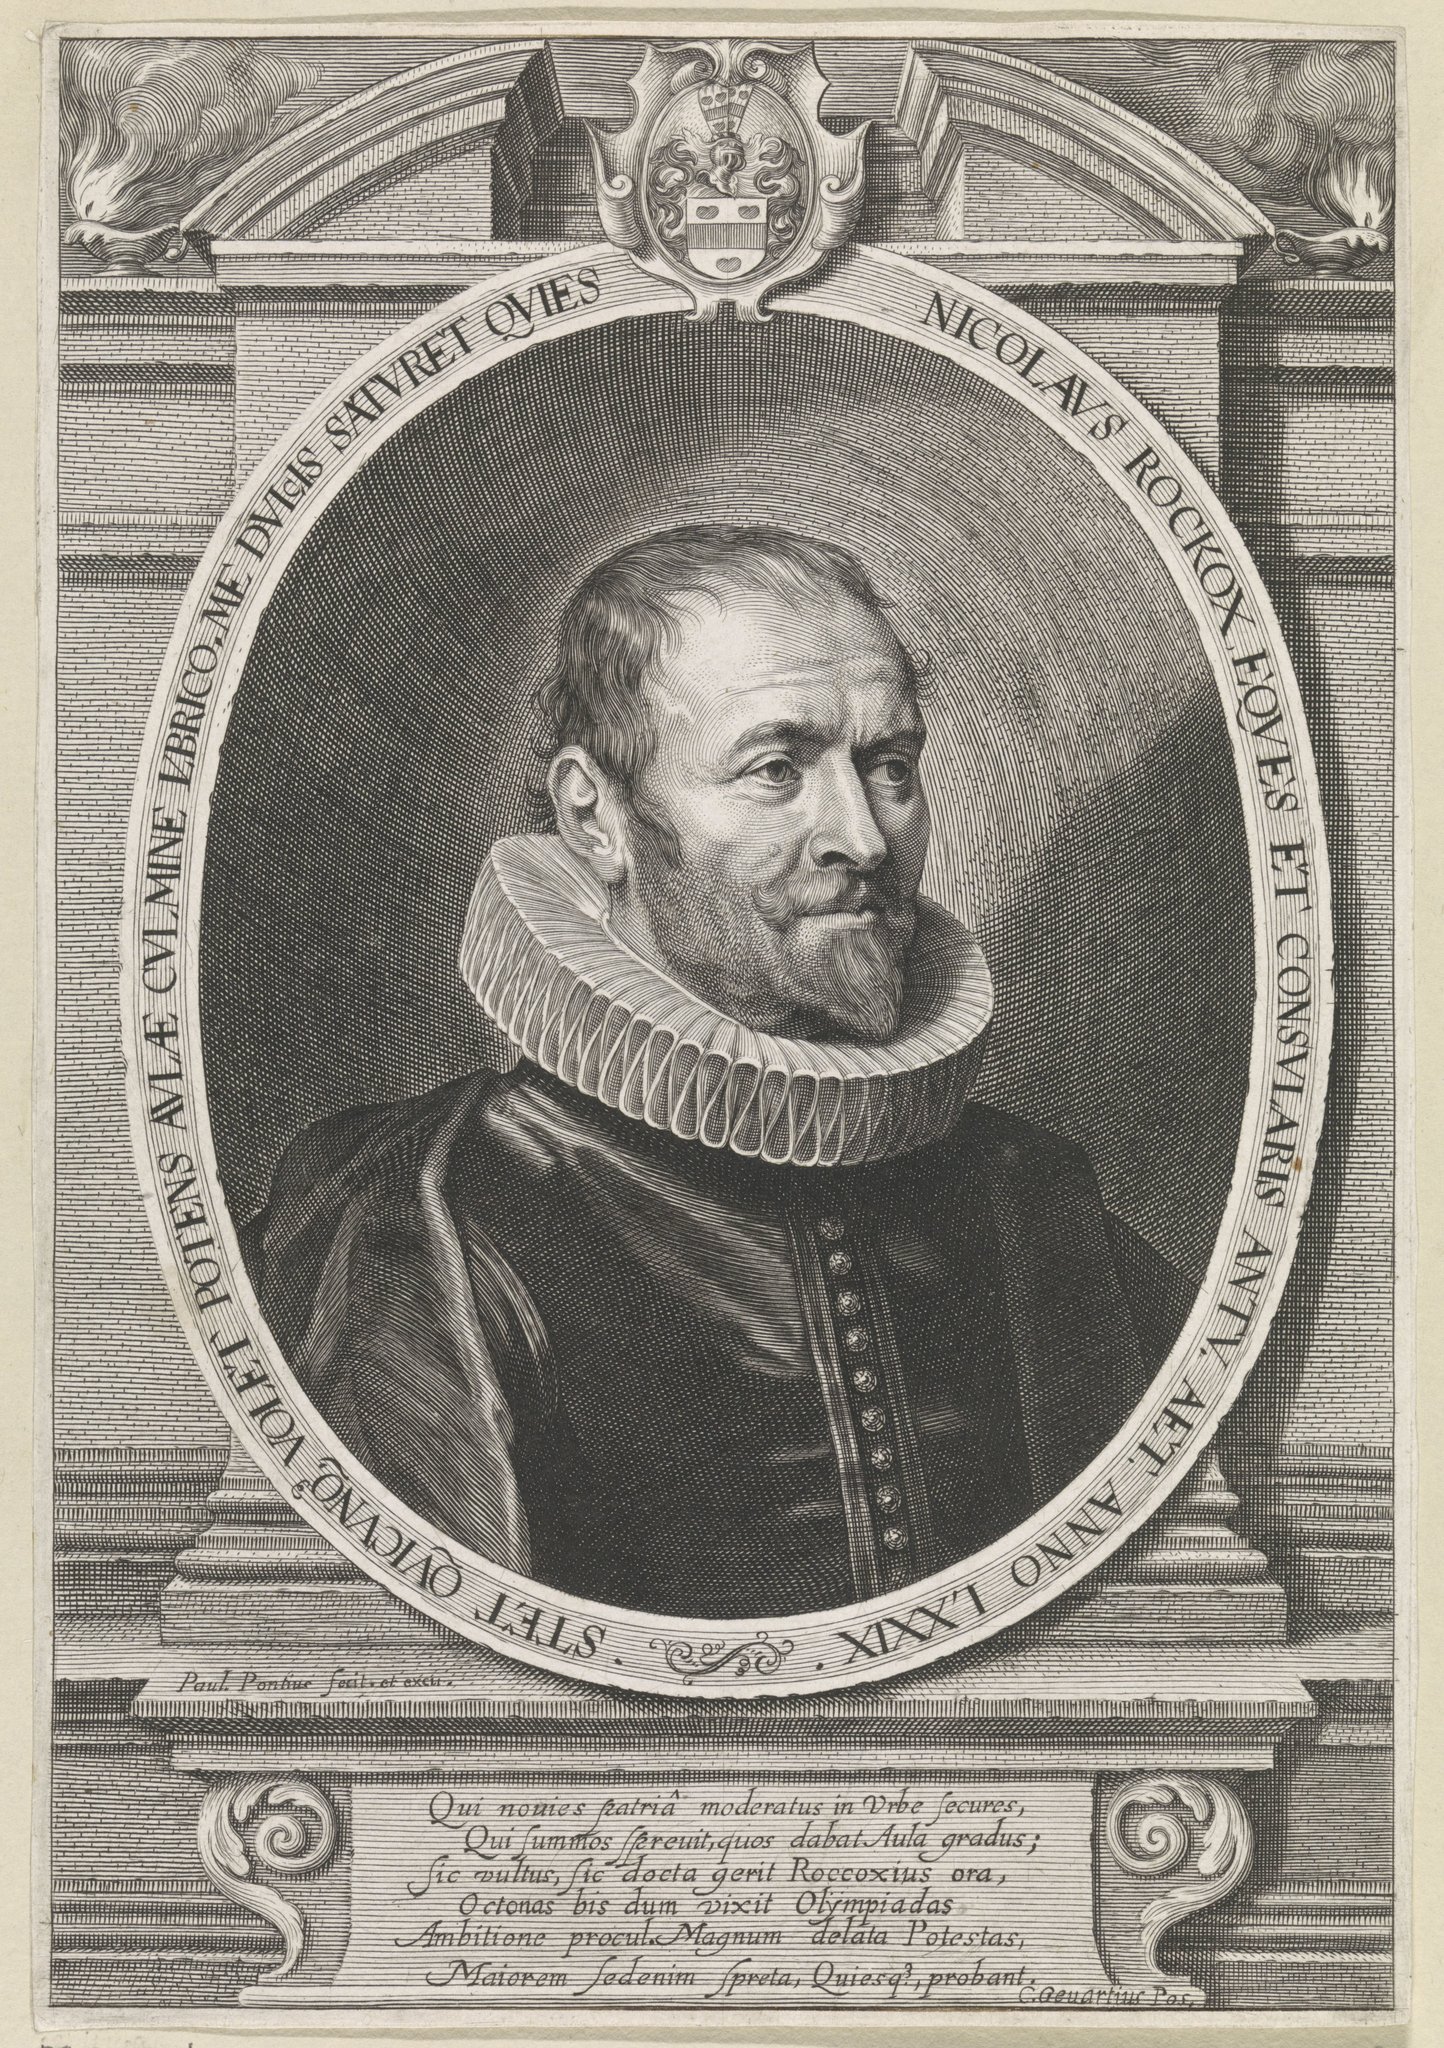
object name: print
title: Portret van Nicolaas Rockox jr., op 79-jarige leeftijd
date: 1639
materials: paper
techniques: engraving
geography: antwerp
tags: antwerp, mayor, nikolaas rockox, armorial bearing, heraldry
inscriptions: collector's mark: Lugt 240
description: Portret van Nicolaas Rockox jr., burgemeester van Antwerpen, bekroond met zijn wapenschild. In het kader op de piëdestal een zesregelig lofdicht in het Latijn.